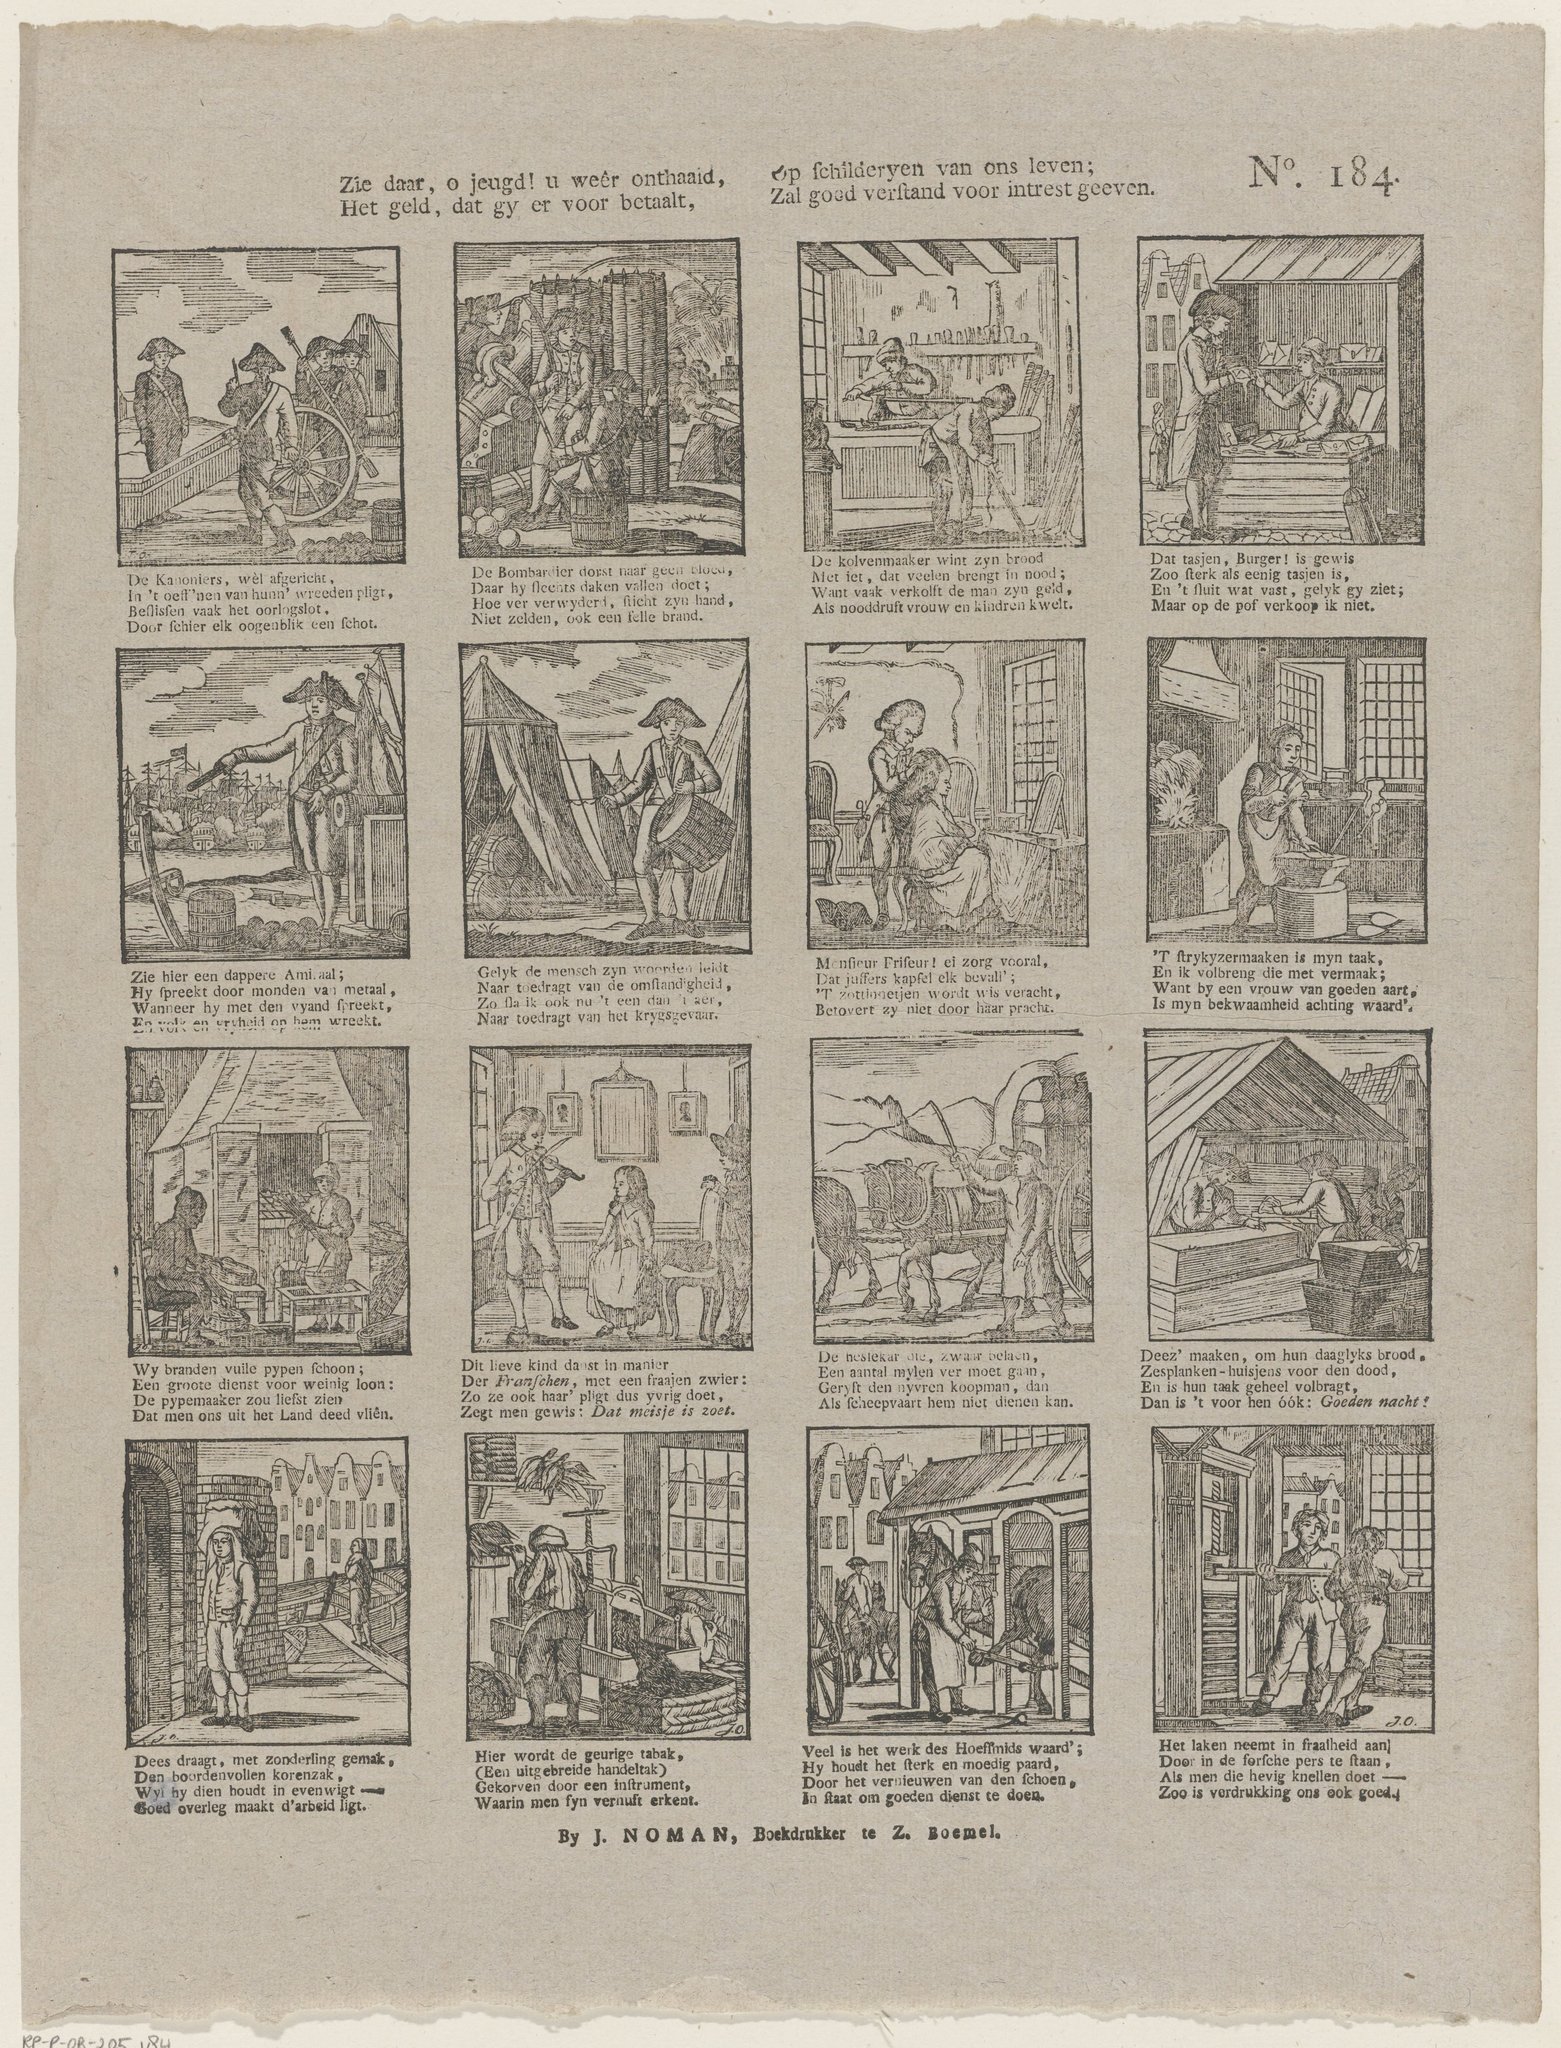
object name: popular print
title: Zie daar, o jeugd! u weêr onthaald, / Het geld, dat gy er voor betaalt, / op schilderyen van ons leven; / Zal goed verstand voor intrest geeven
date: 1806-1830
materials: paper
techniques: letterpress printing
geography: netherlands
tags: musician at work, craft-production, skilled handiwork, the soldier; the soldier's life, barber, barbershop, crafts and industries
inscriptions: collector's mark: Lugt 2760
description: Blad met 16 voorstellingen van ambachtslieden en beroepen, zoals soldaat, kapper en hoefsmid. Onder elke afbeelding een vierregelig vers. Genummerd rechtsboven: No. 184.